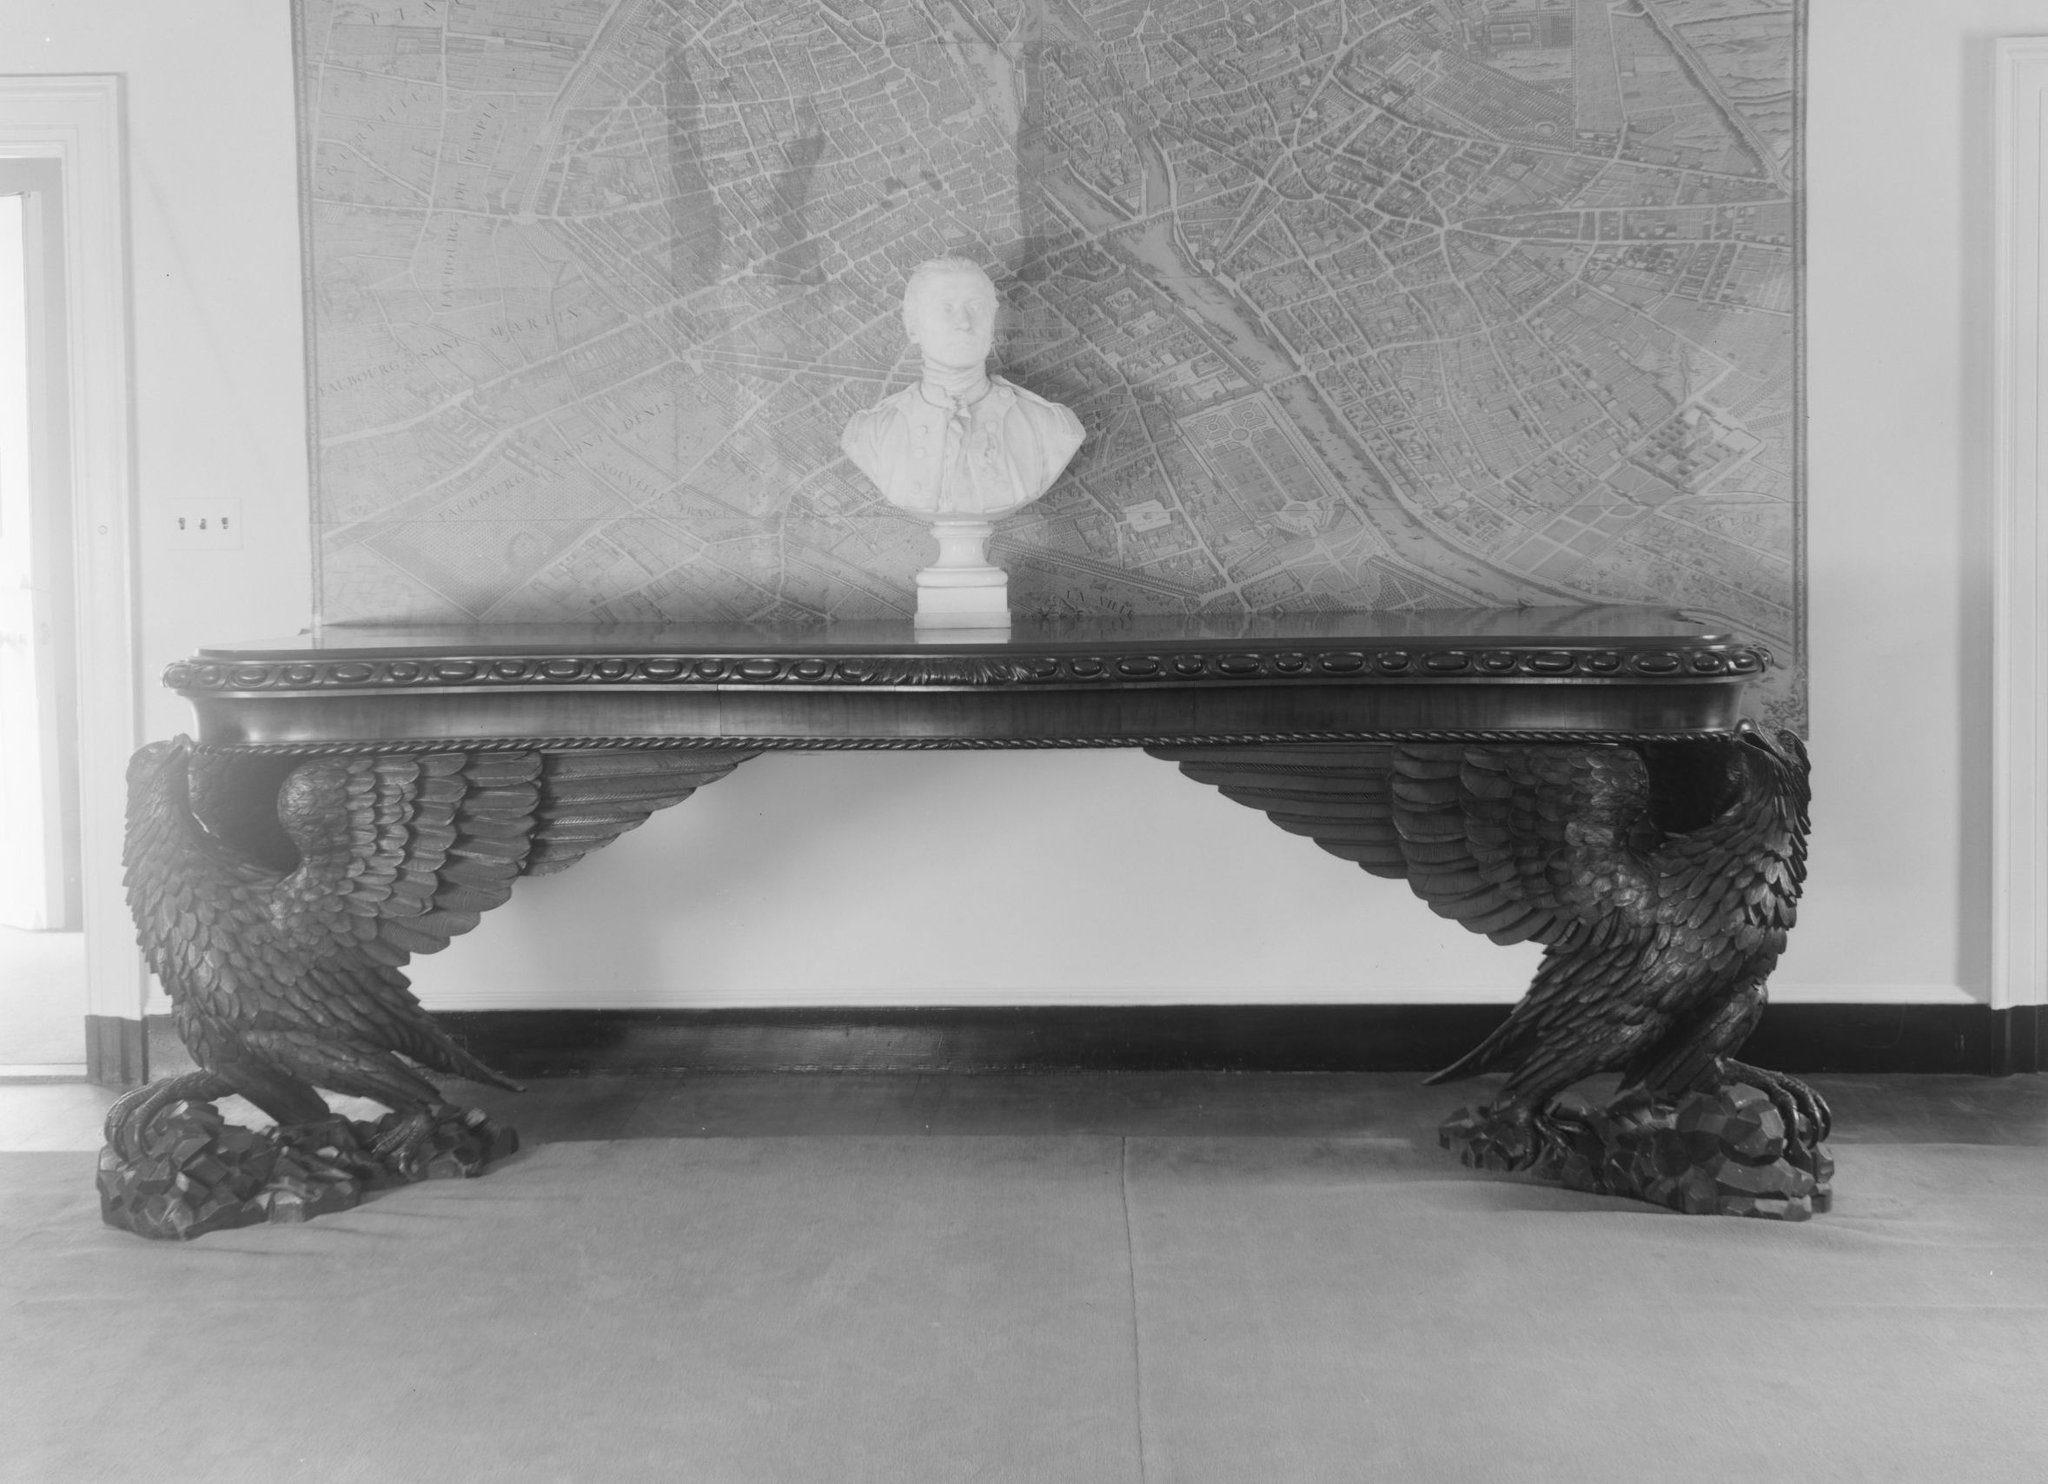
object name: pier table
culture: american or british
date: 1830-1850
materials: wood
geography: england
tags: eagles